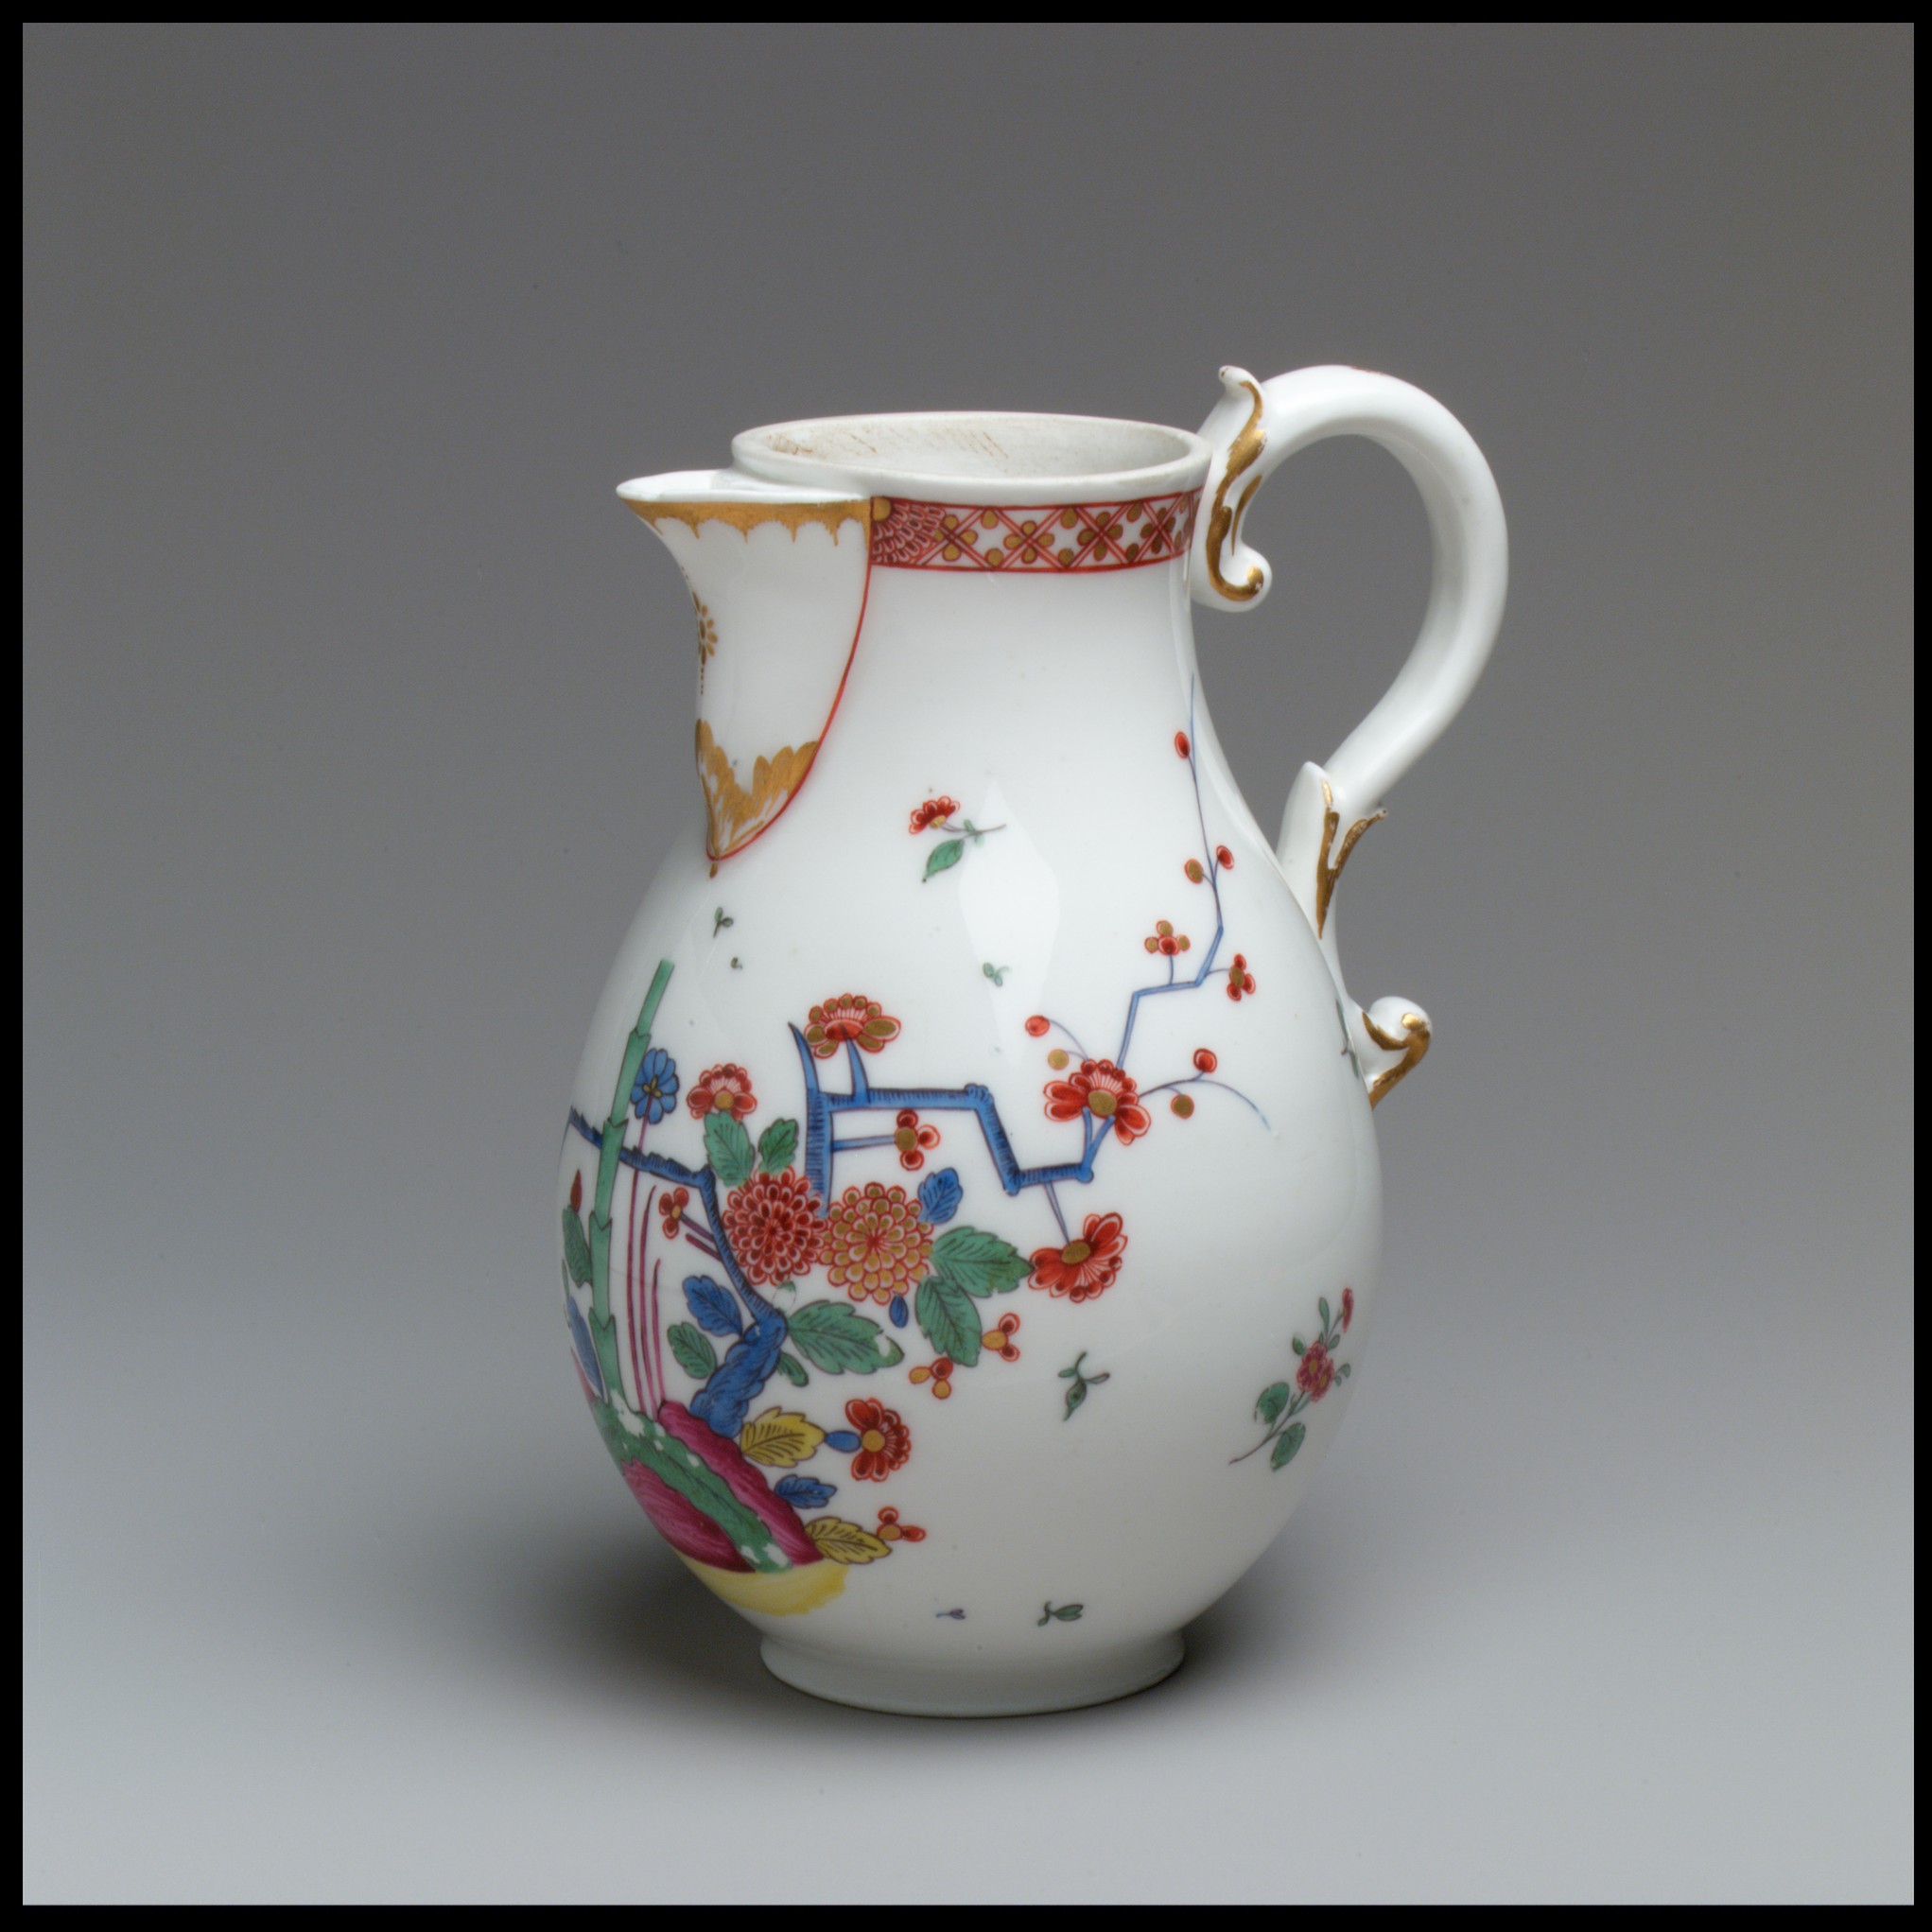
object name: milk pot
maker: loosdrecht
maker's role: factory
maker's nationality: dutch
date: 1780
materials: hard paste porcelain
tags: flowers